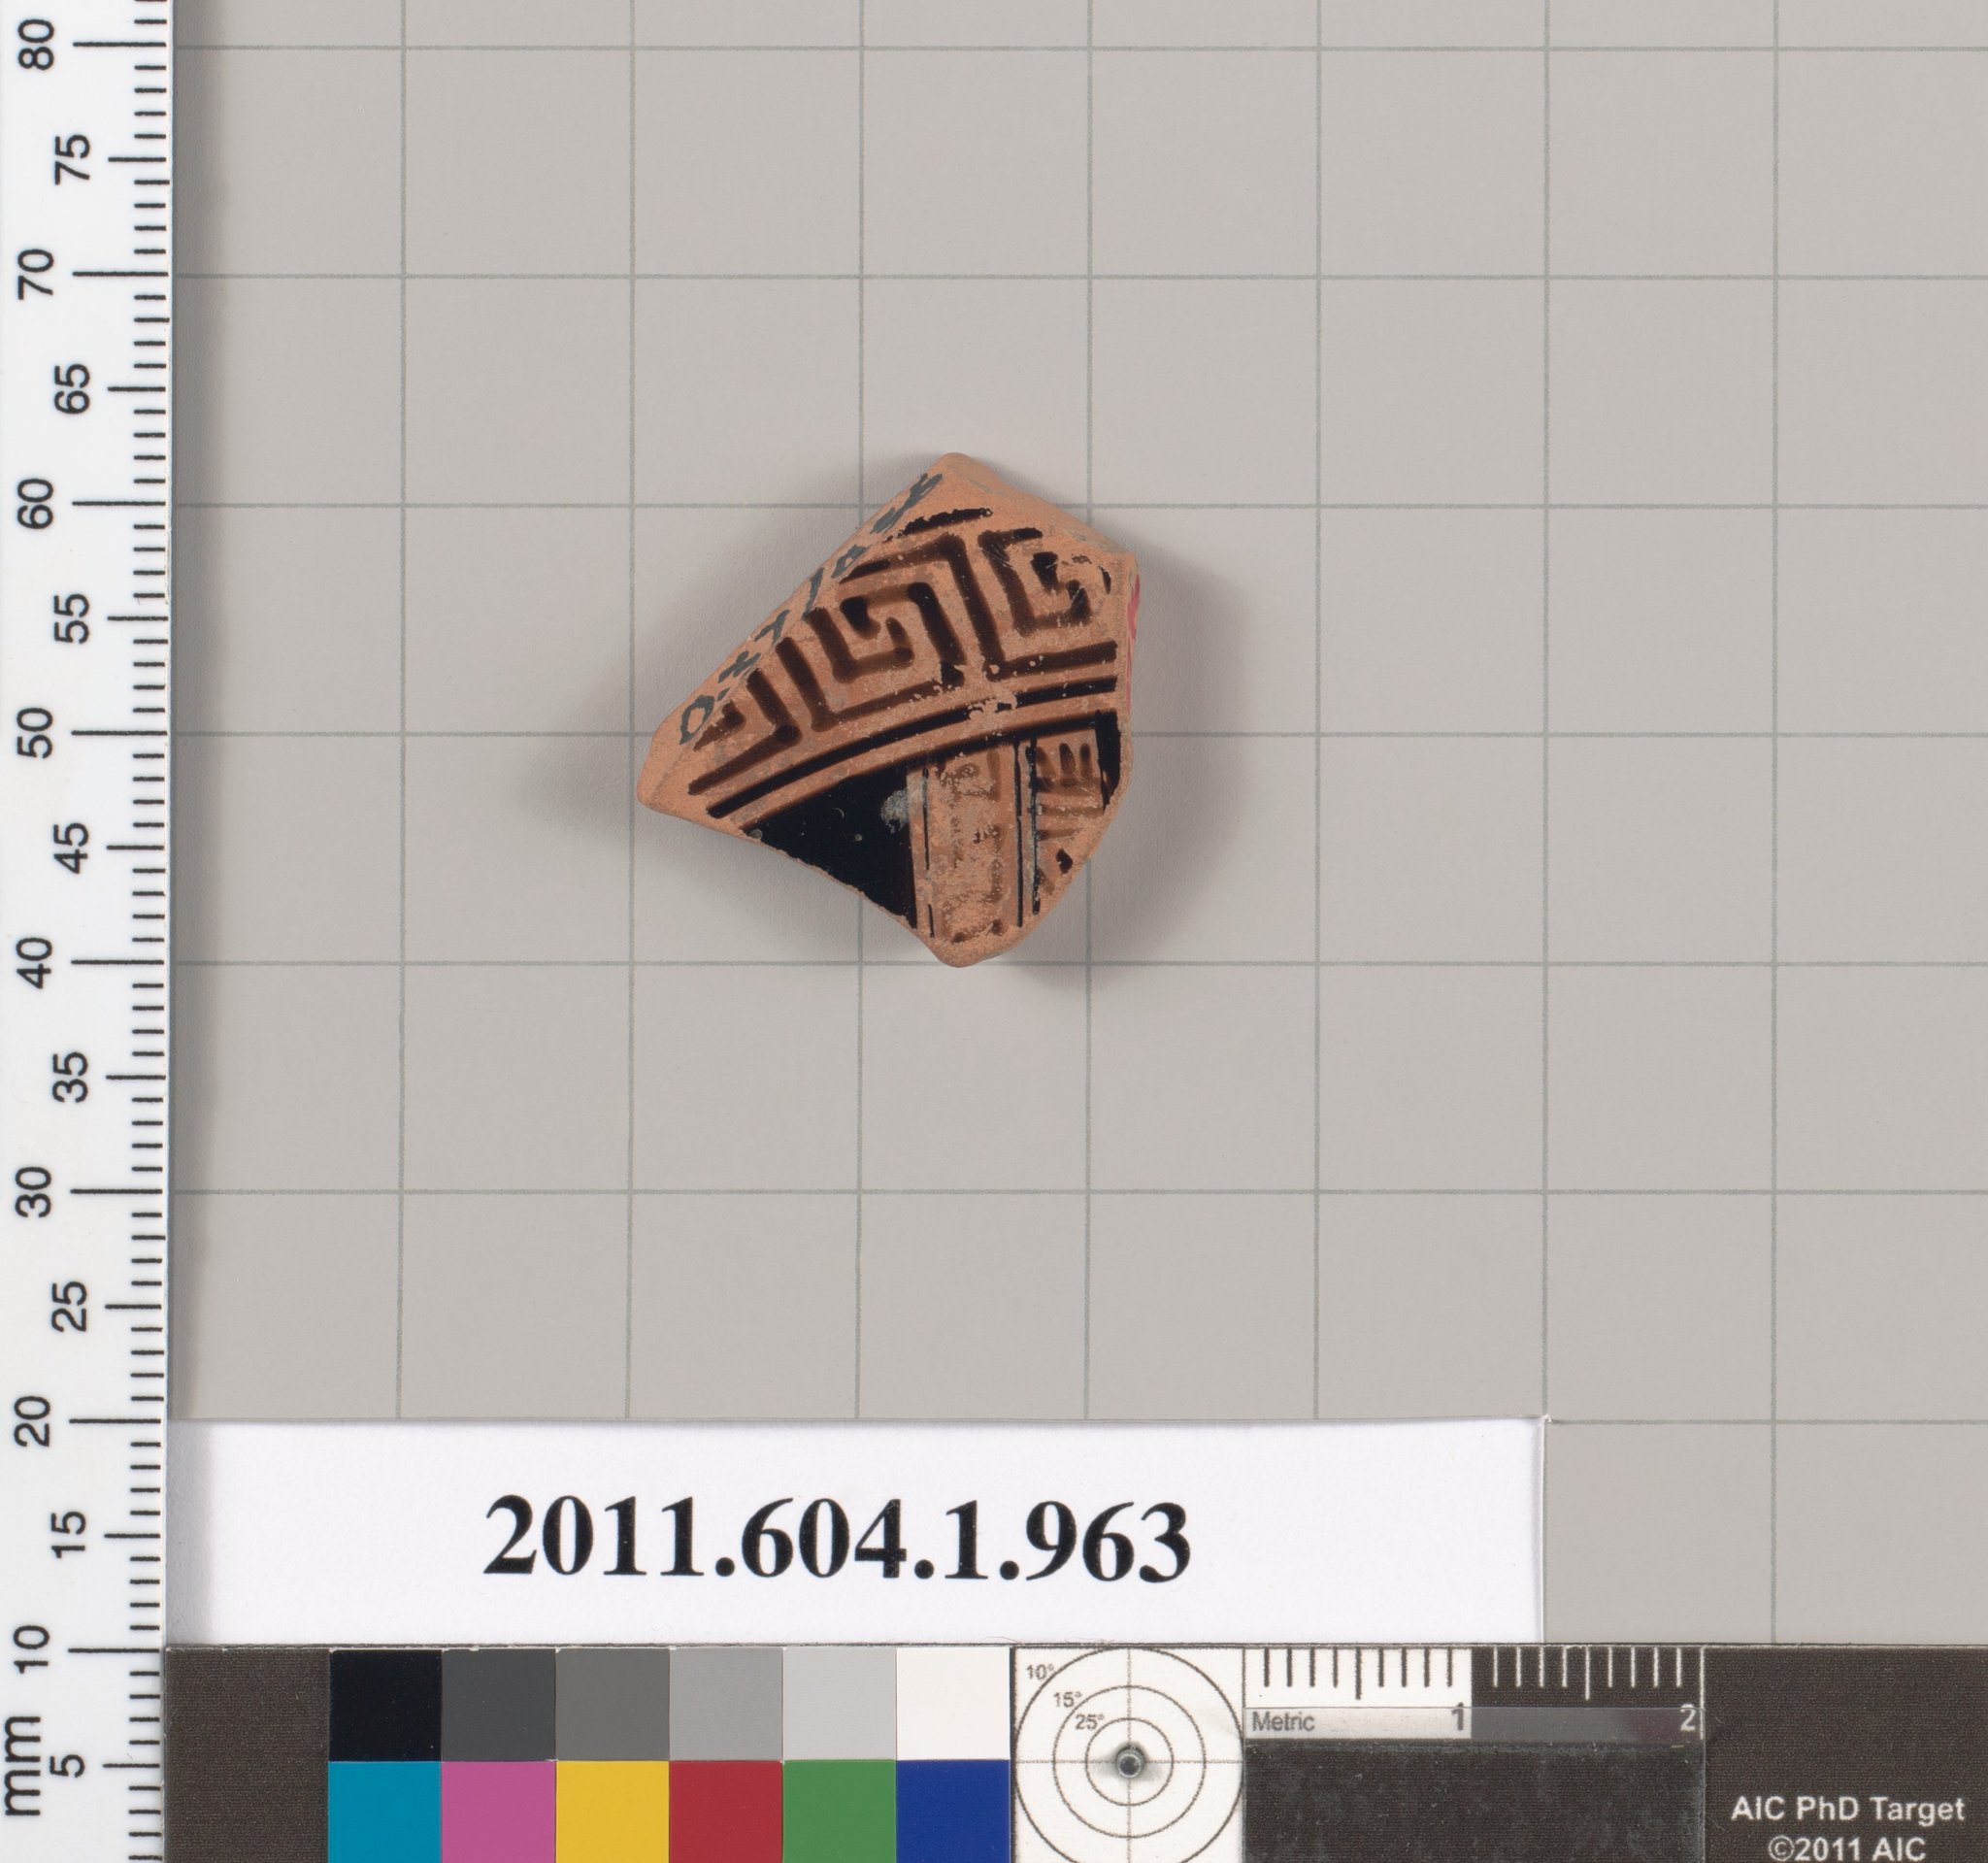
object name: kylix fragment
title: Terracotta fragment of a kylix (drinking cup)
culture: greek, attic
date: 490-480 BCE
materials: terracotta